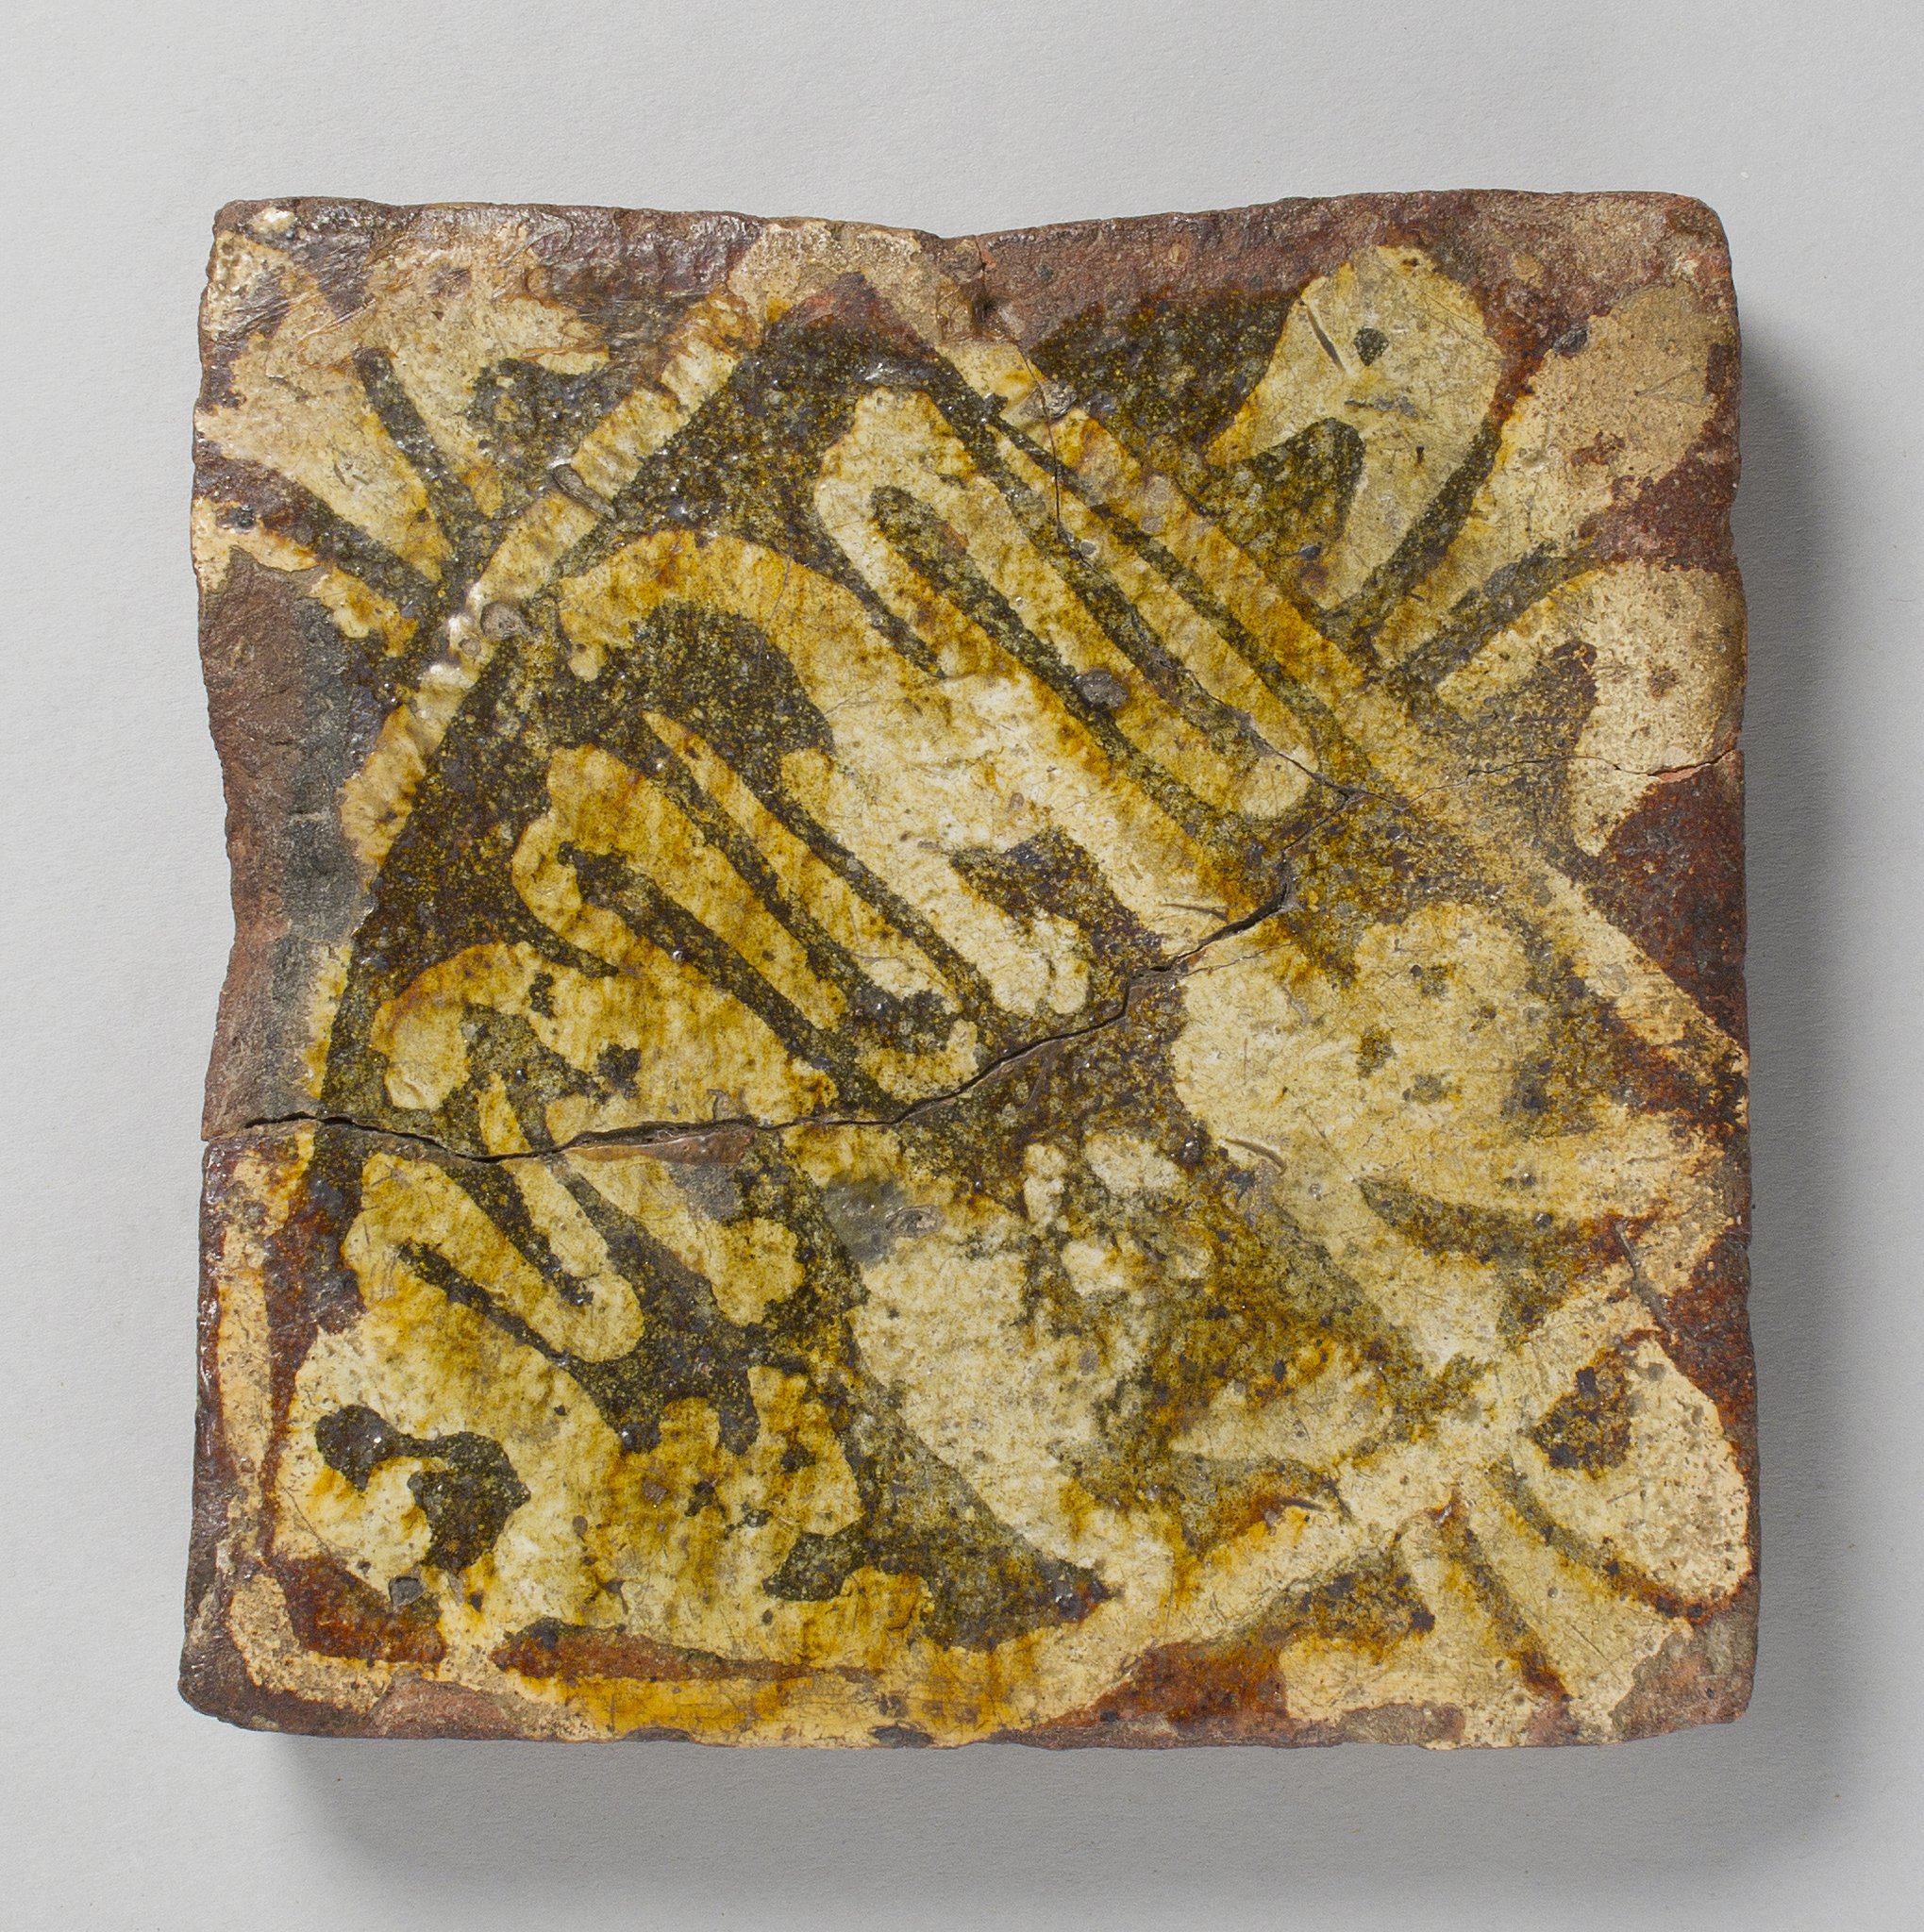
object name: tile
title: Two-Colored Tile with arms of England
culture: british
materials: earthenware, glaze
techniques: firing